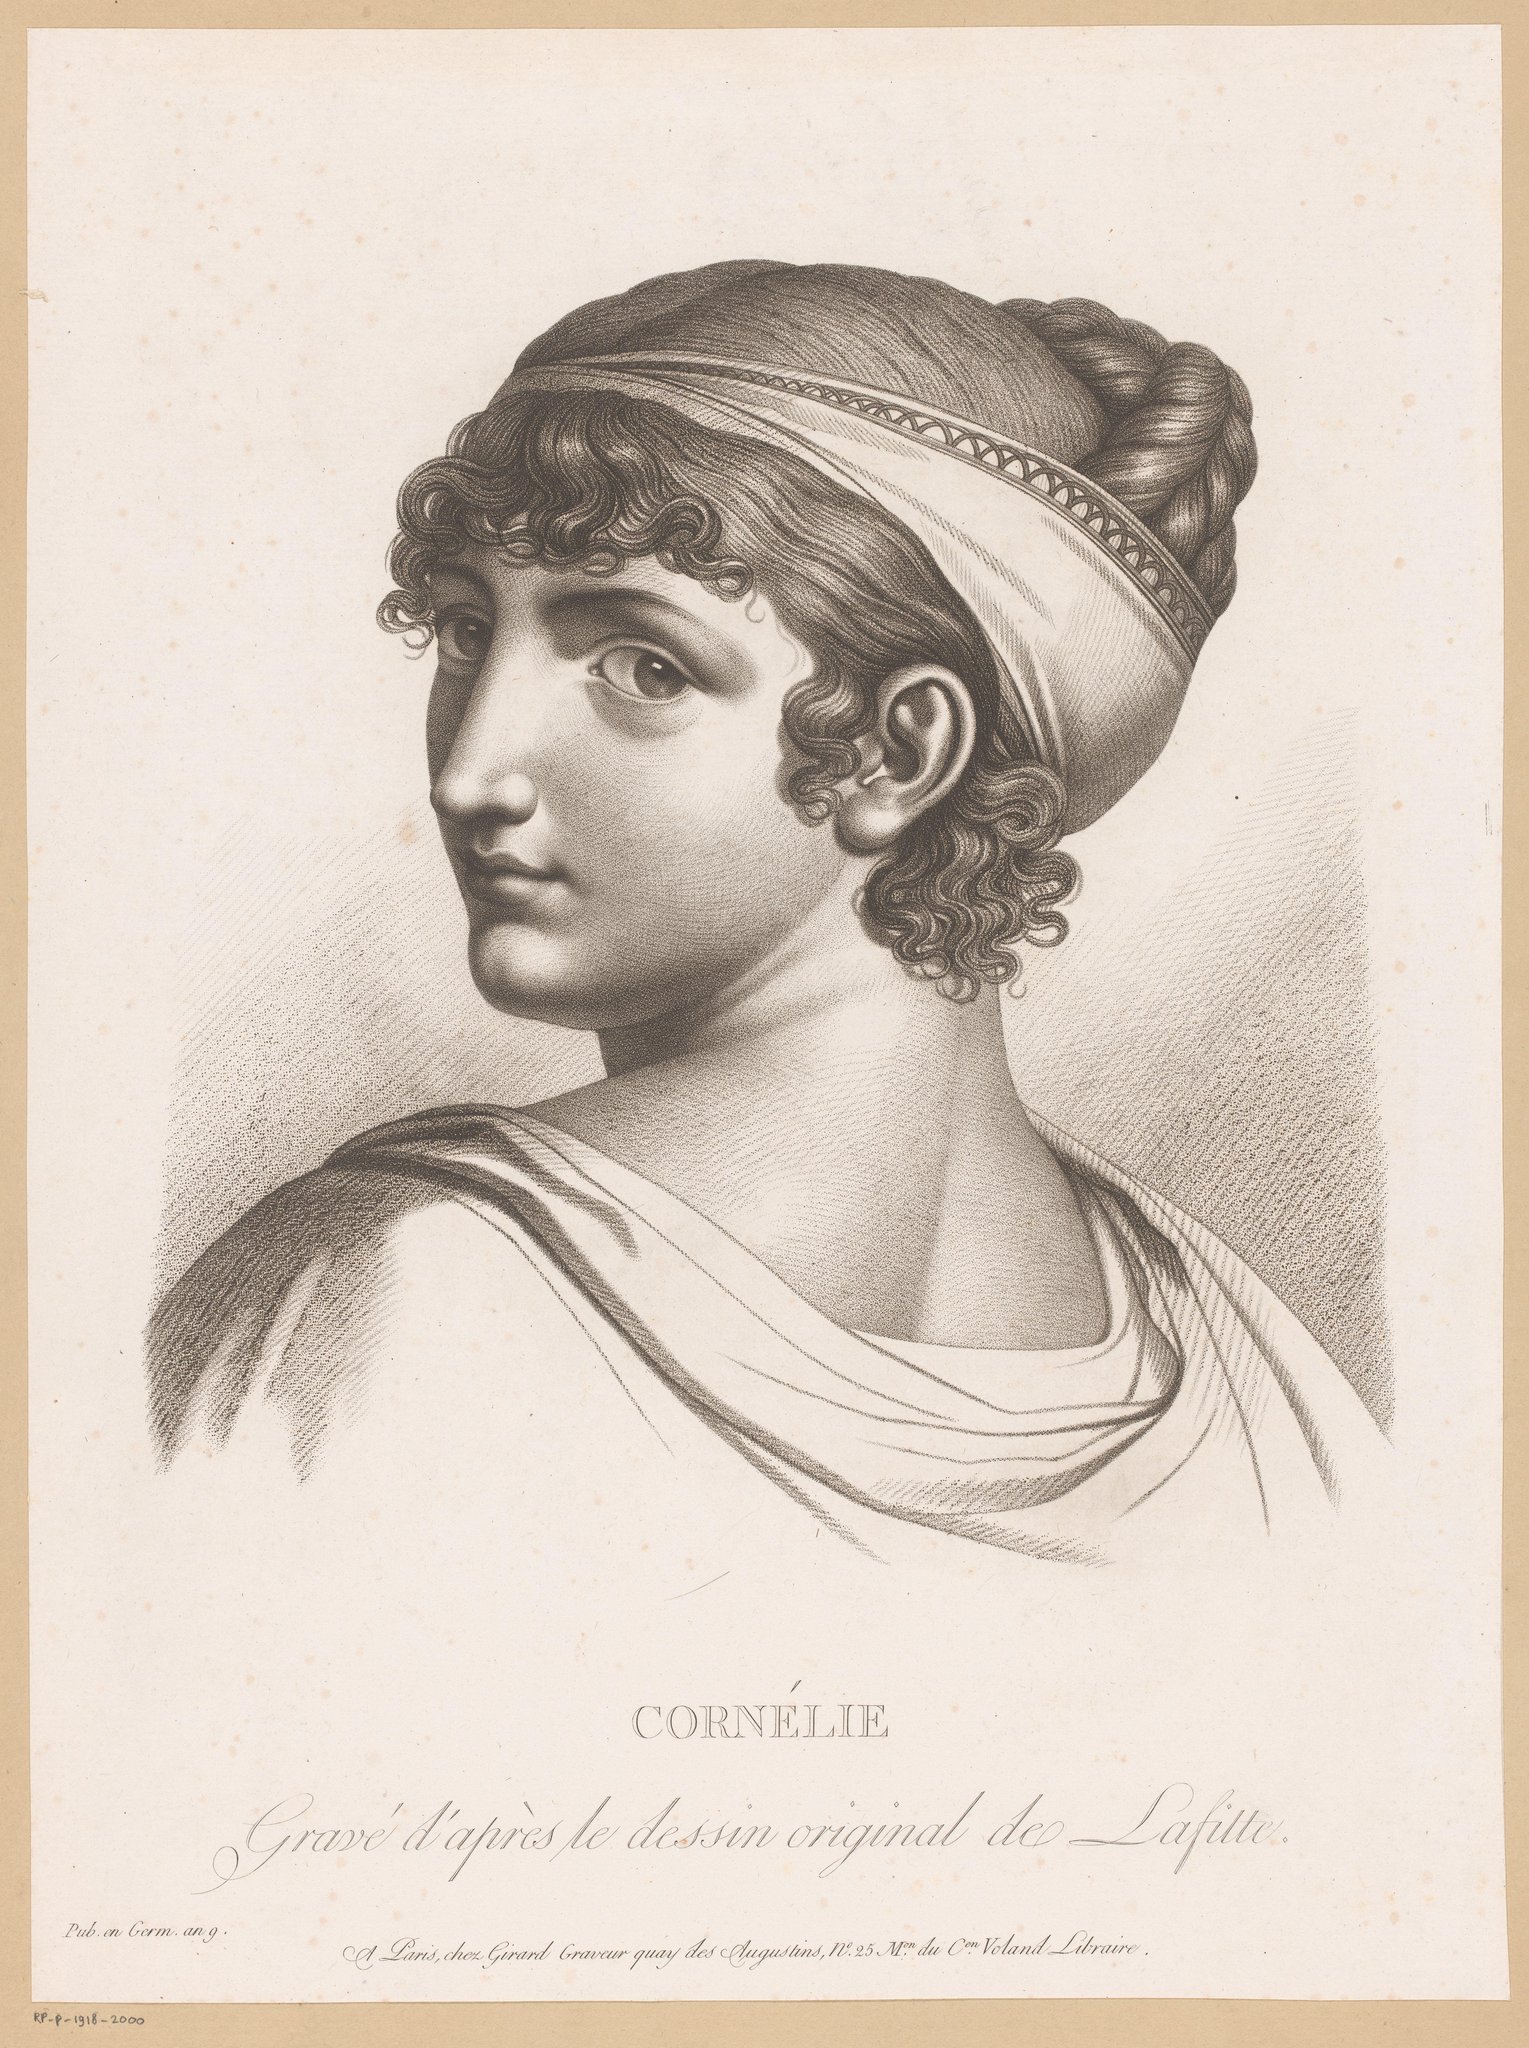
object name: print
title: Portret van een onbekende vrouw genaamd Cornélie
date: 1809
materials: paper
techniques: engraving, roulette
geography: france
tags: historical persons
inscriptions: collector's mark: Lugt 2233